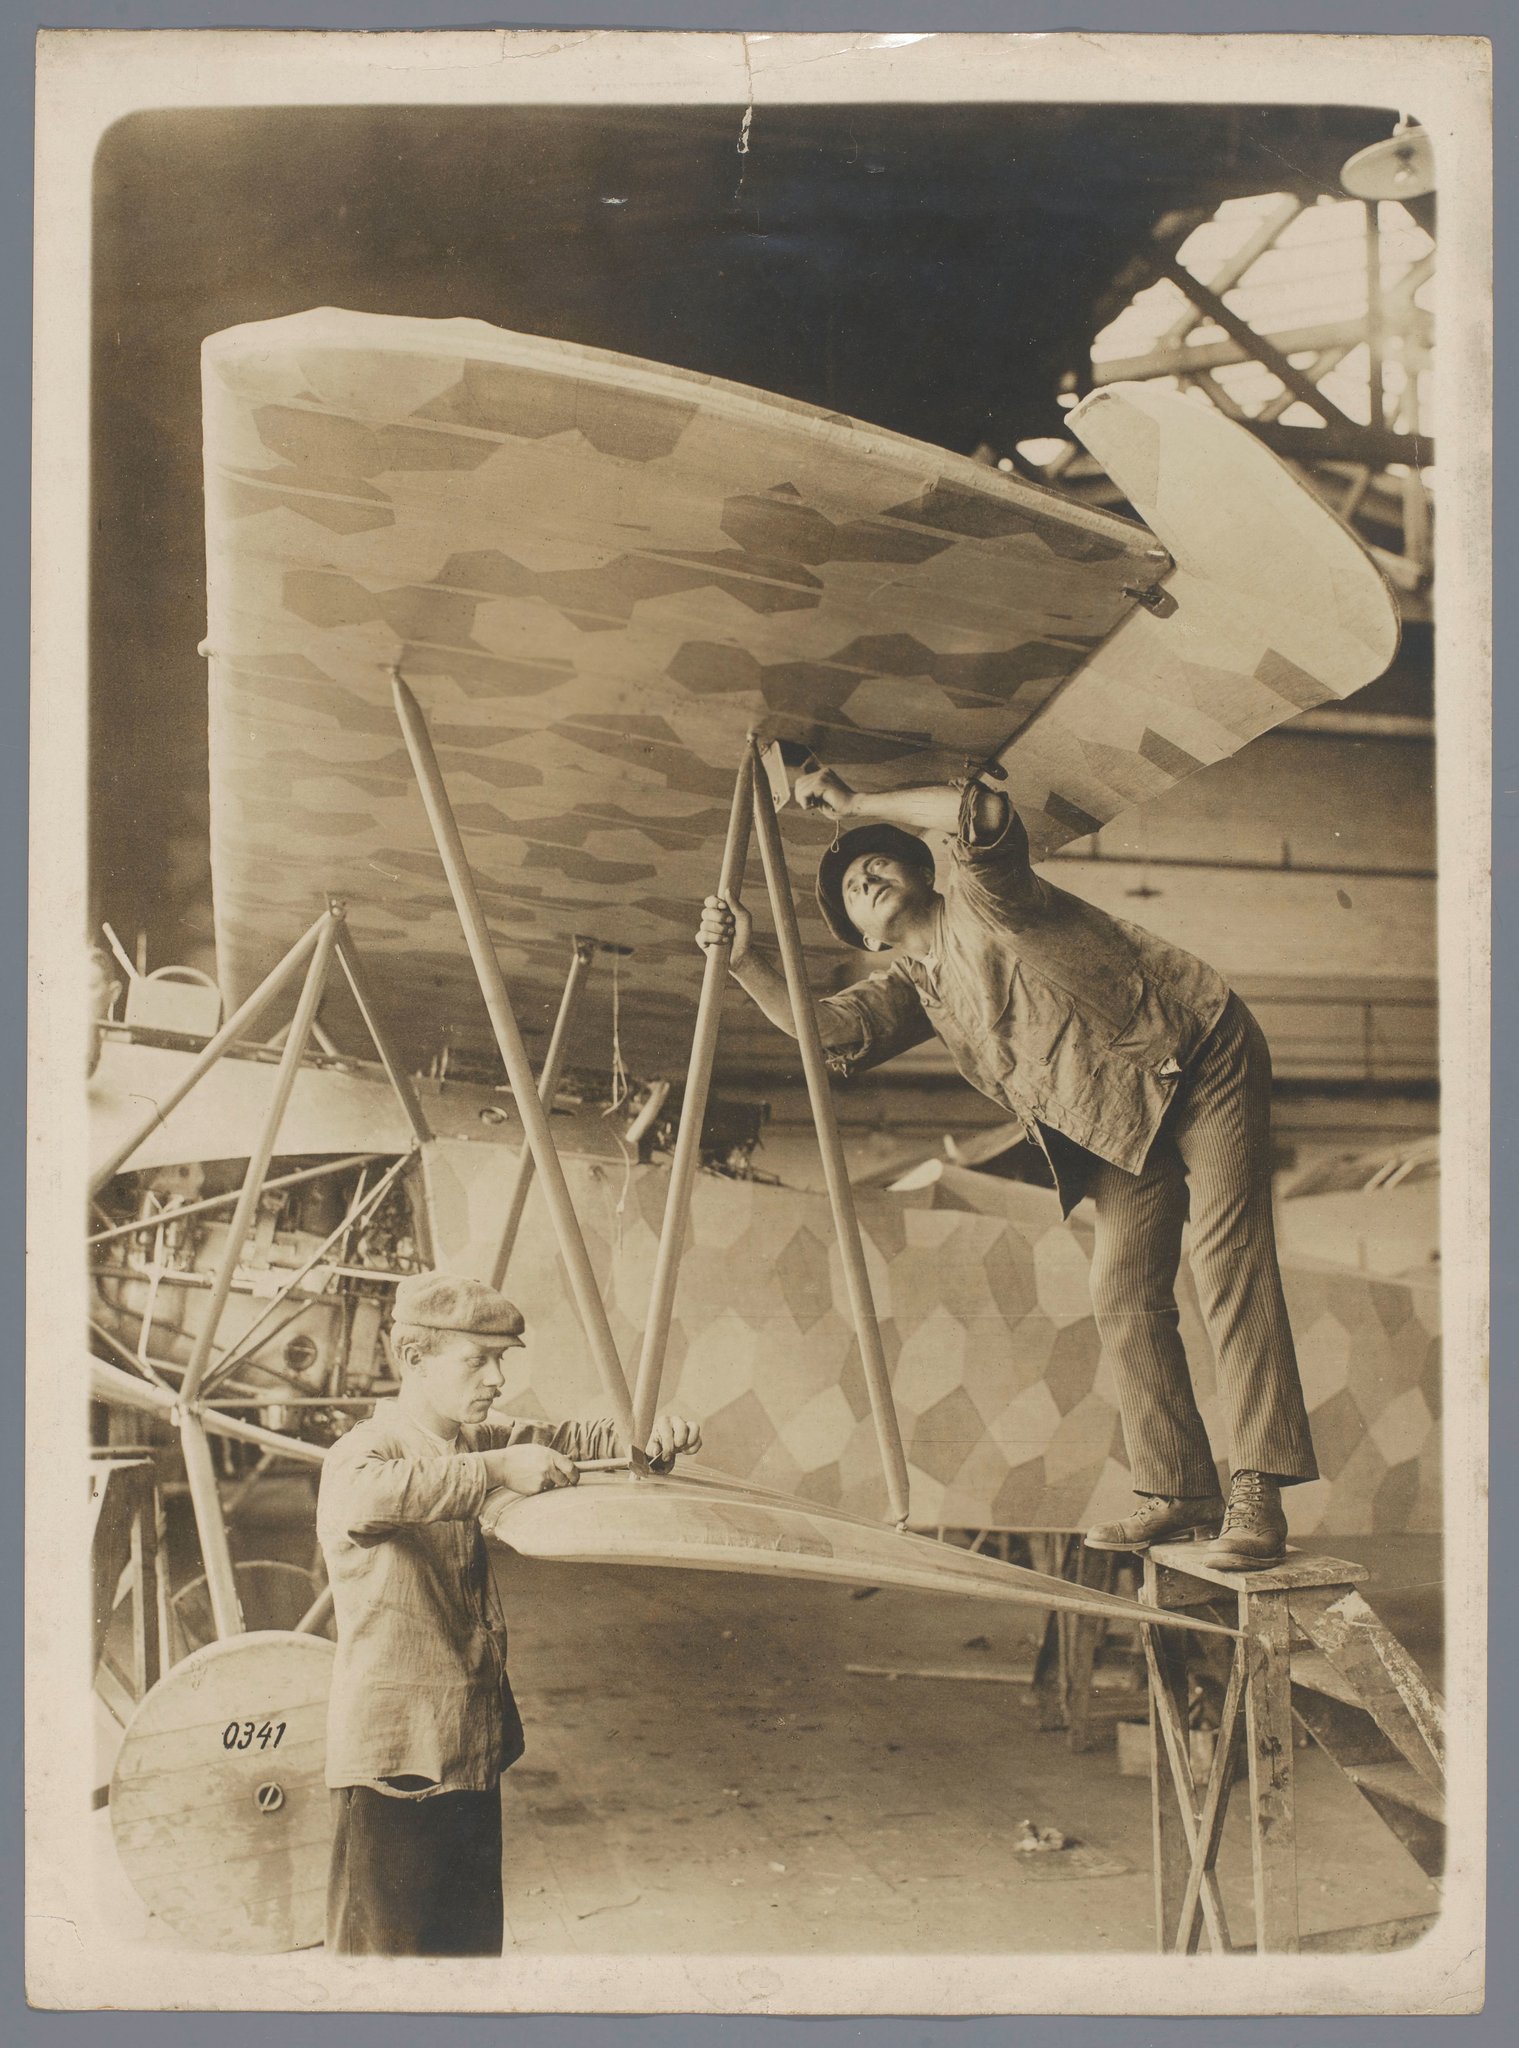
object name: photograph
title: Mechanics and a Fokker D VII fighter plane with camouflage pattern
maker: Anonymous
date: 1918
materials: paper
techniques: gelatin silver print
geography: germany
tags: aircraft, aeroplane, ground crew ~ aviation, germany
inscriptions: number: ‘0341’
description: Photography was used in the First World War as a means of propaganda. These shots were probably taken by a military photographer or a photographer in the service of a press agency on the German and Austrian-Hungarian side. To keep the home front informed, shows of photographs were already being held during the war. The large format of these photographs suggests that they were displayed in such an exhibition.